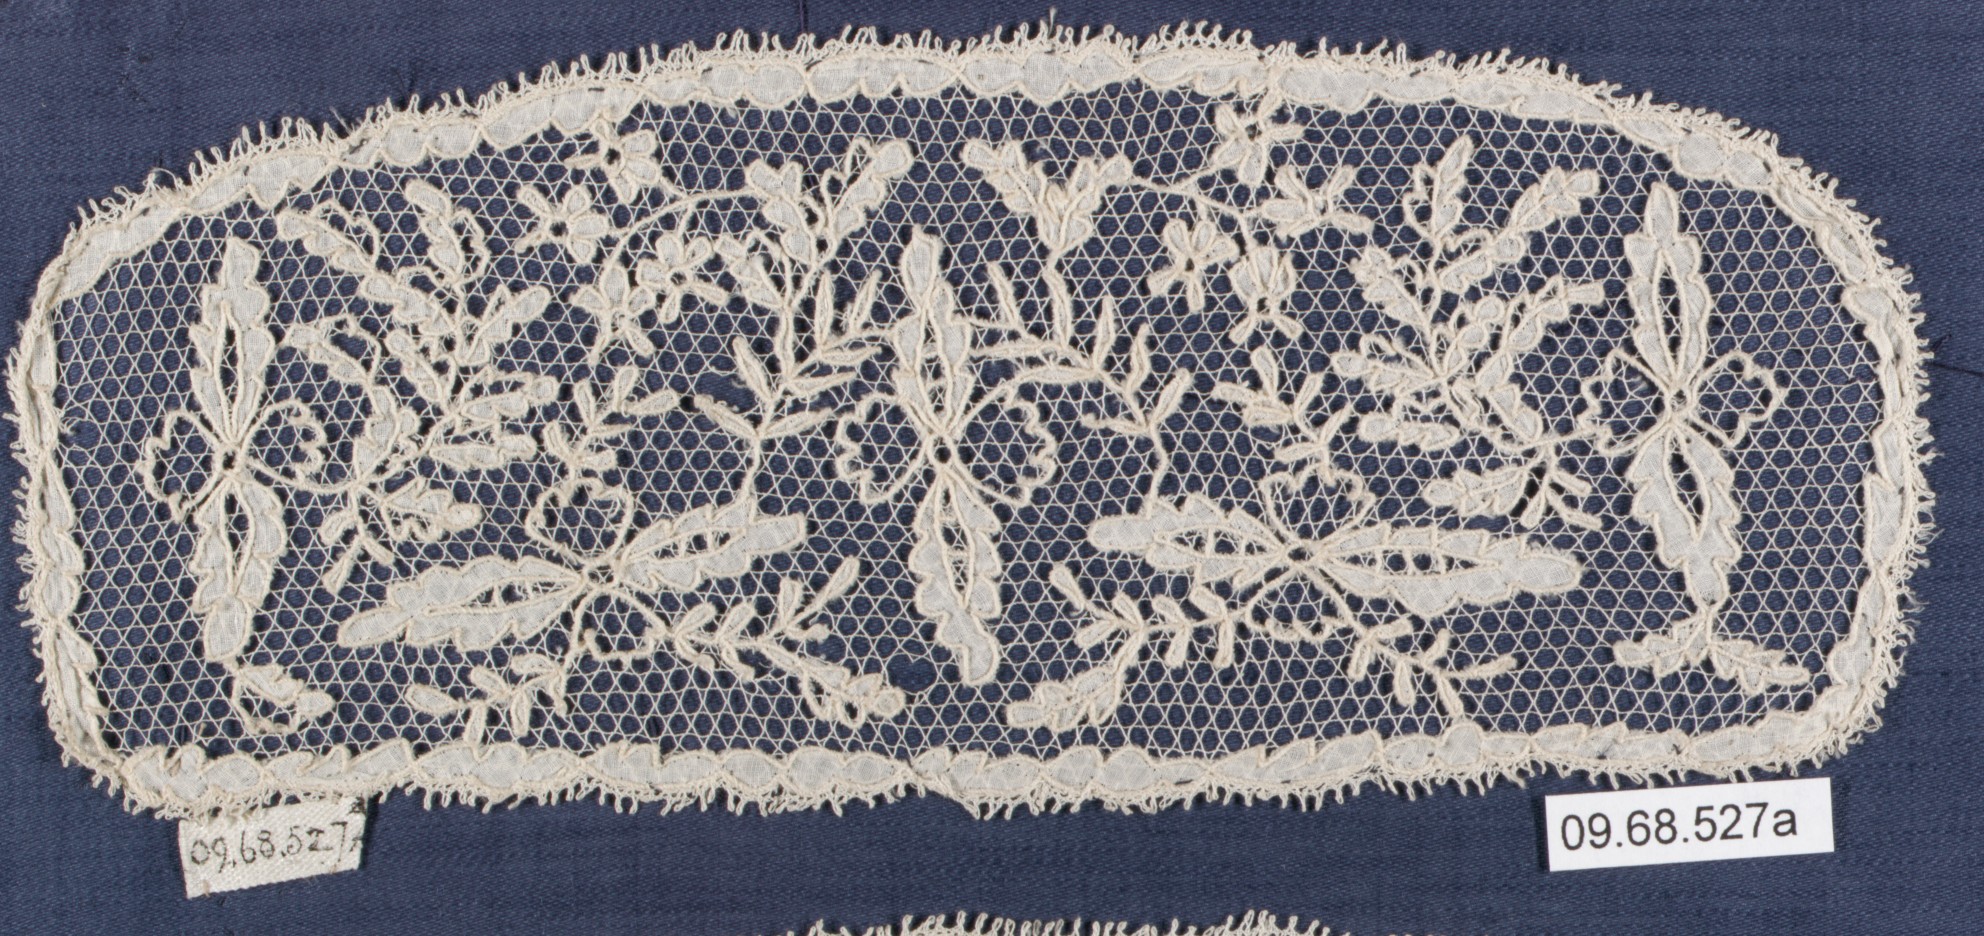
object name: cuff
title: Cuffs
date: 1801-1900